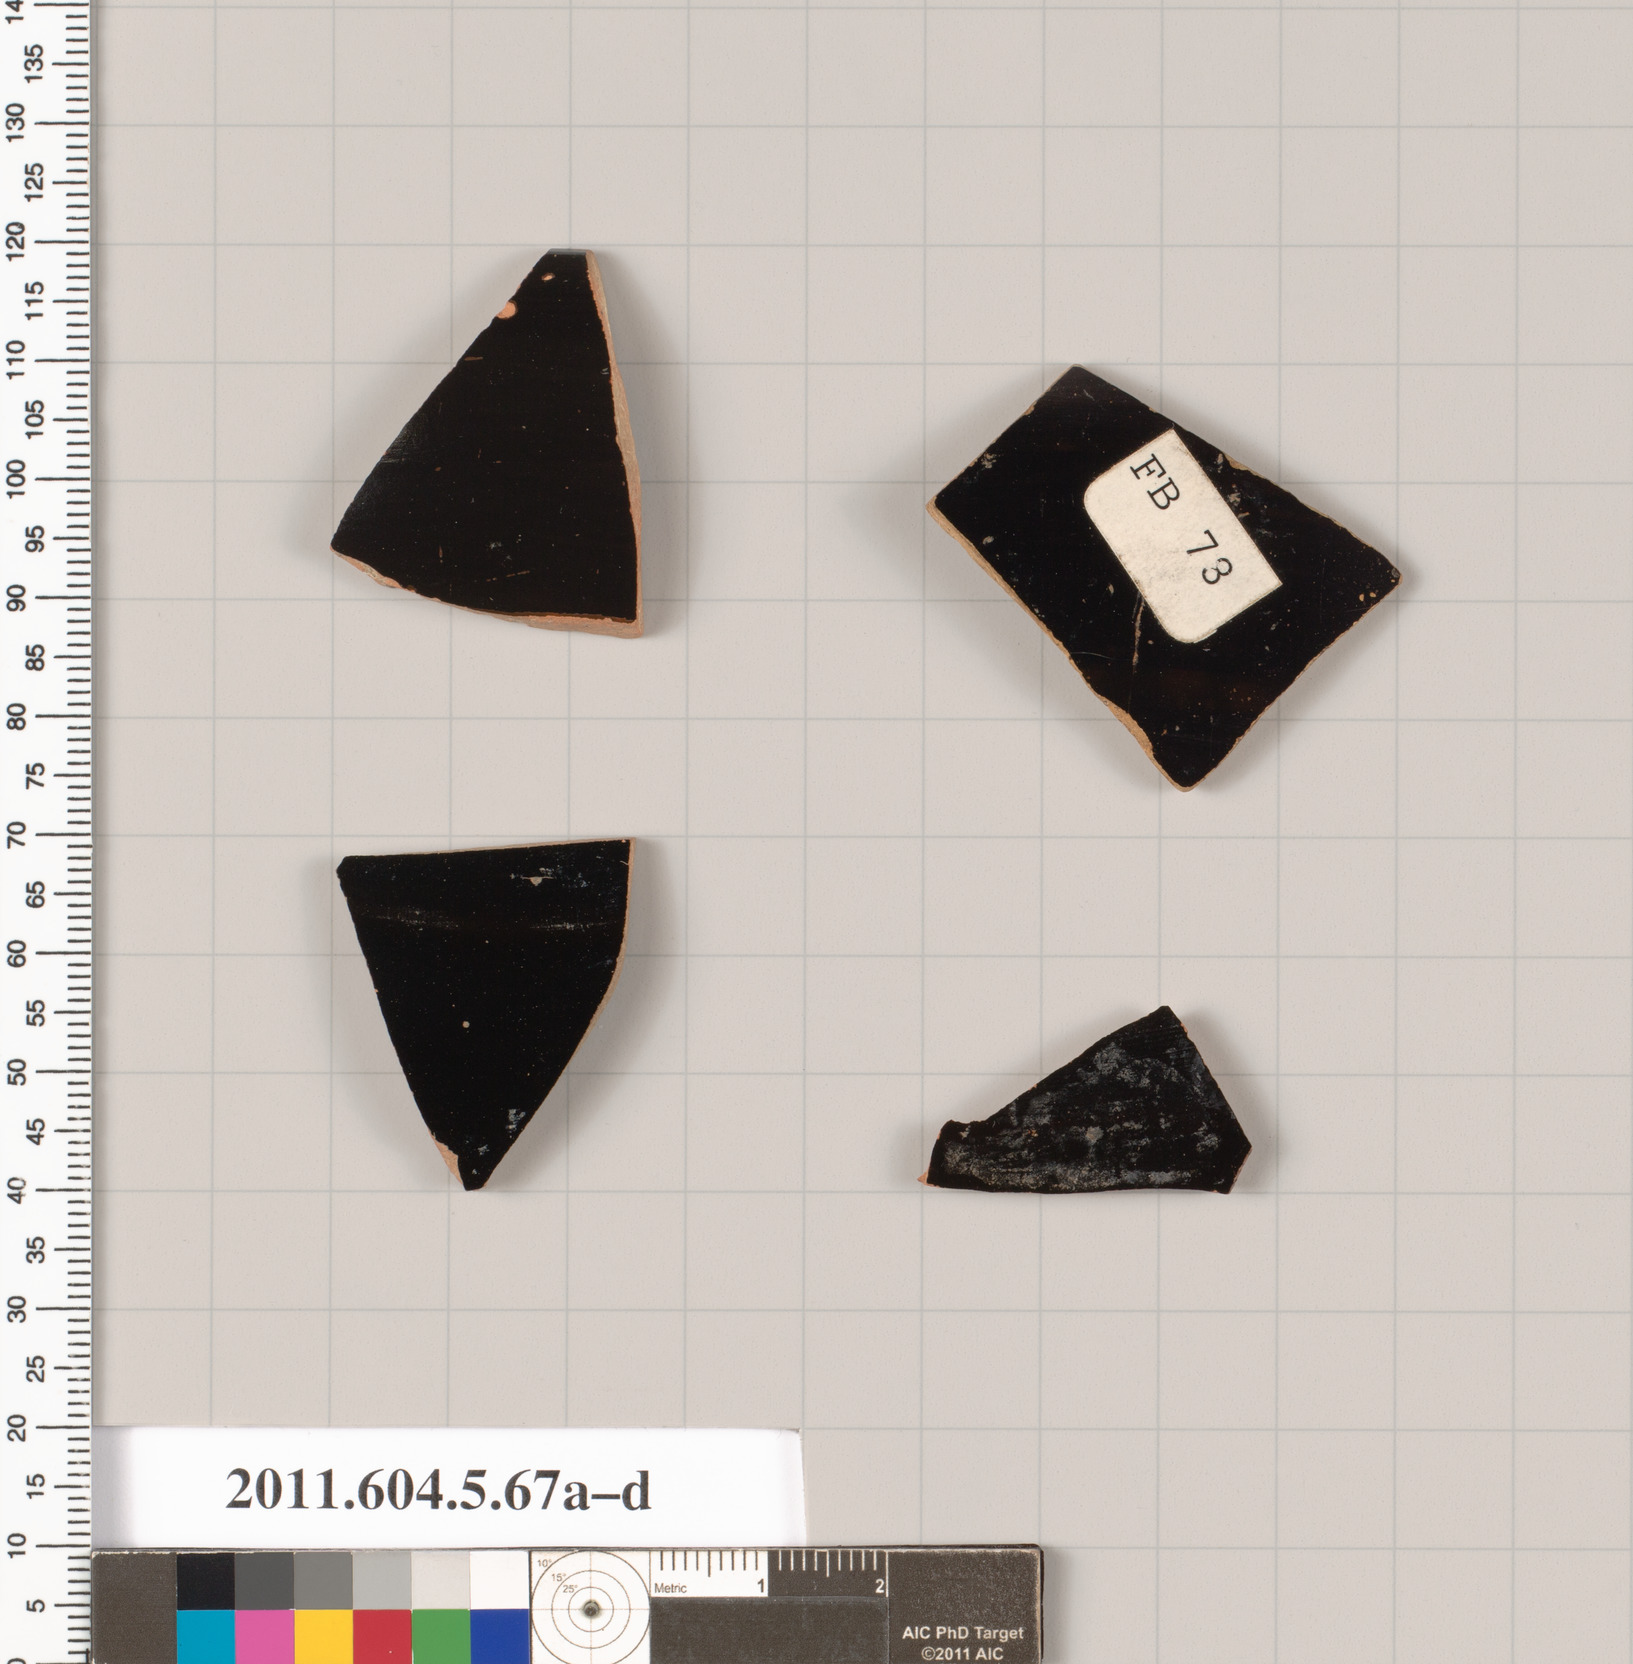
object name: kylix fragment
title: Terracotta fragments of kylikes (drinking cups)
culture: greek, attic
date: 500-476 BCE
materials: terracotta